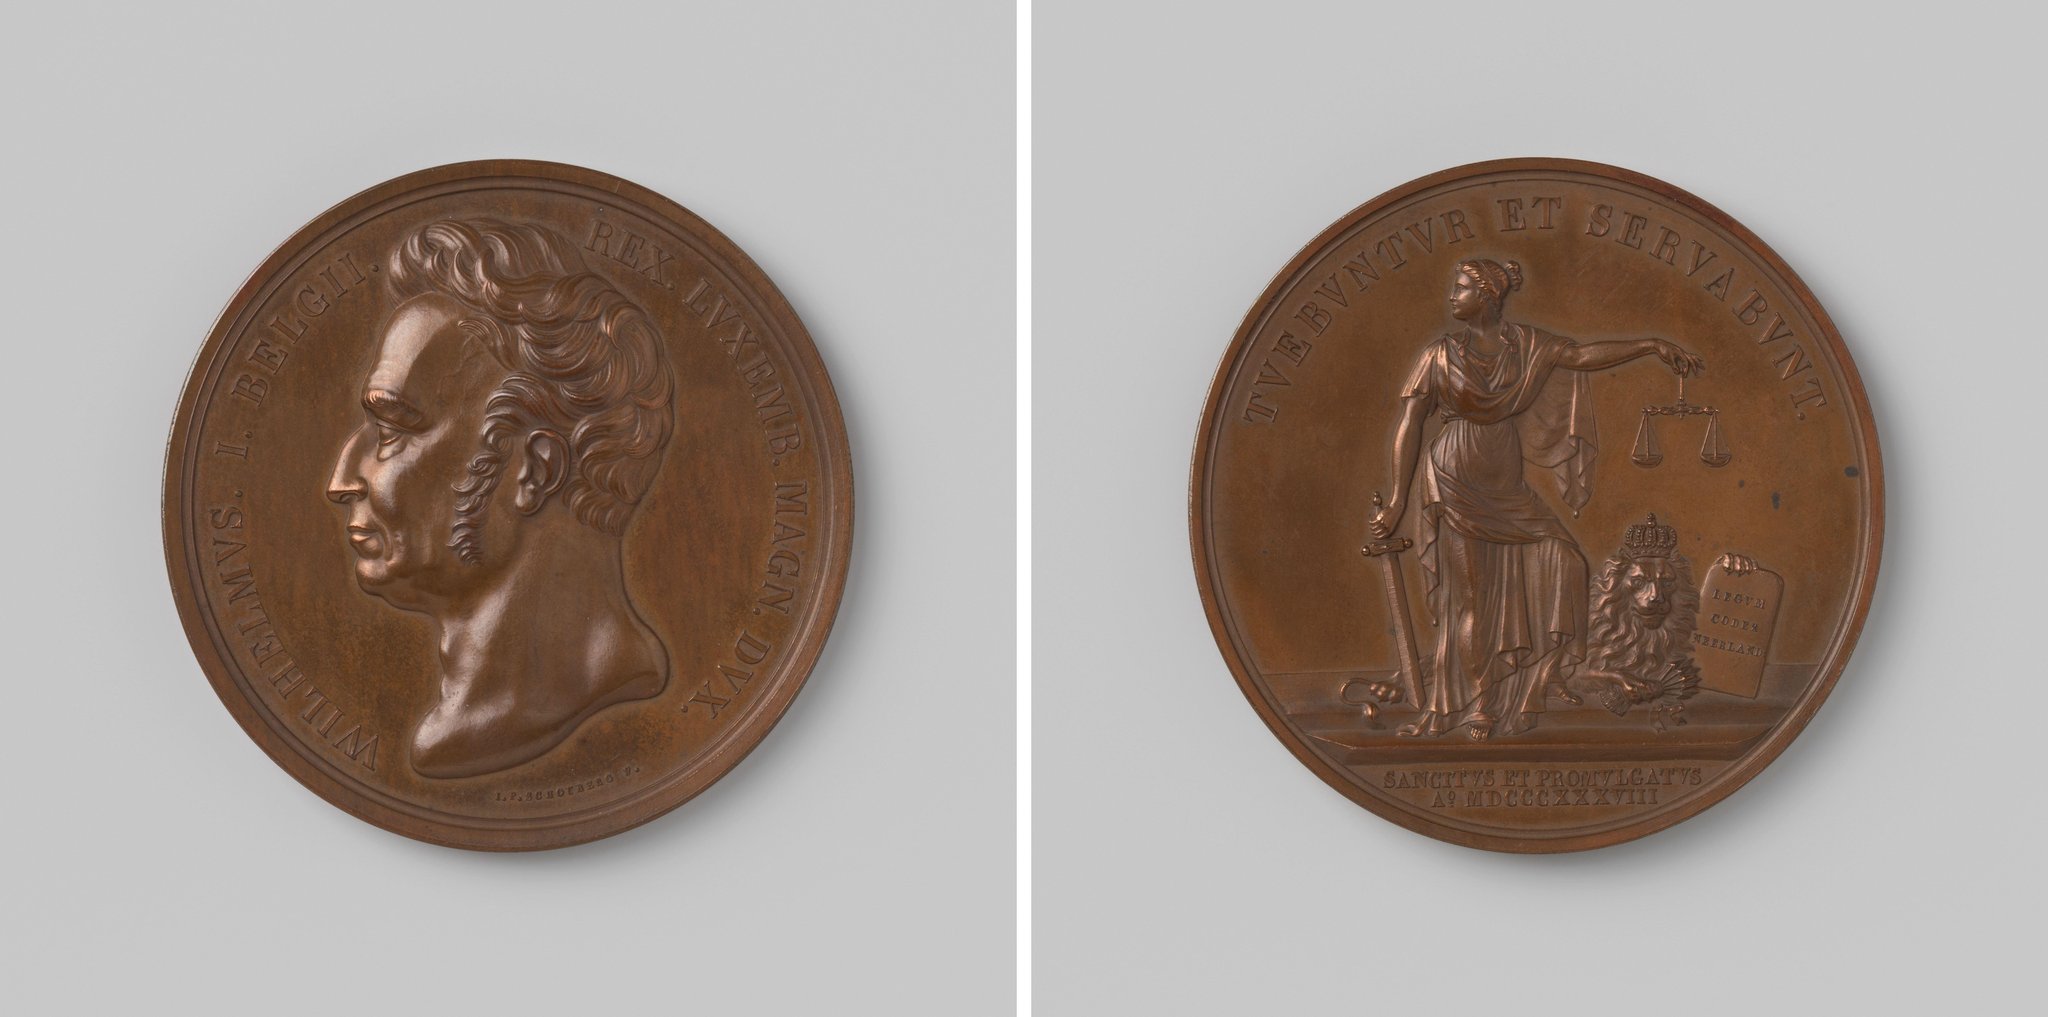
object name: history medal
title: Invoering van de nieuwe Nederlandse wetgeving, ter ere van Willem I Frederik, koning der Nederlanden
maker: johannis petrus schouberg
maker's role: die cutter, draughtsman, print maker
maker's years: 1798-1864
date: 1838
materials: bronze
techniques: striking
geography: utrecht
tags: berlin, william i of the netherlands